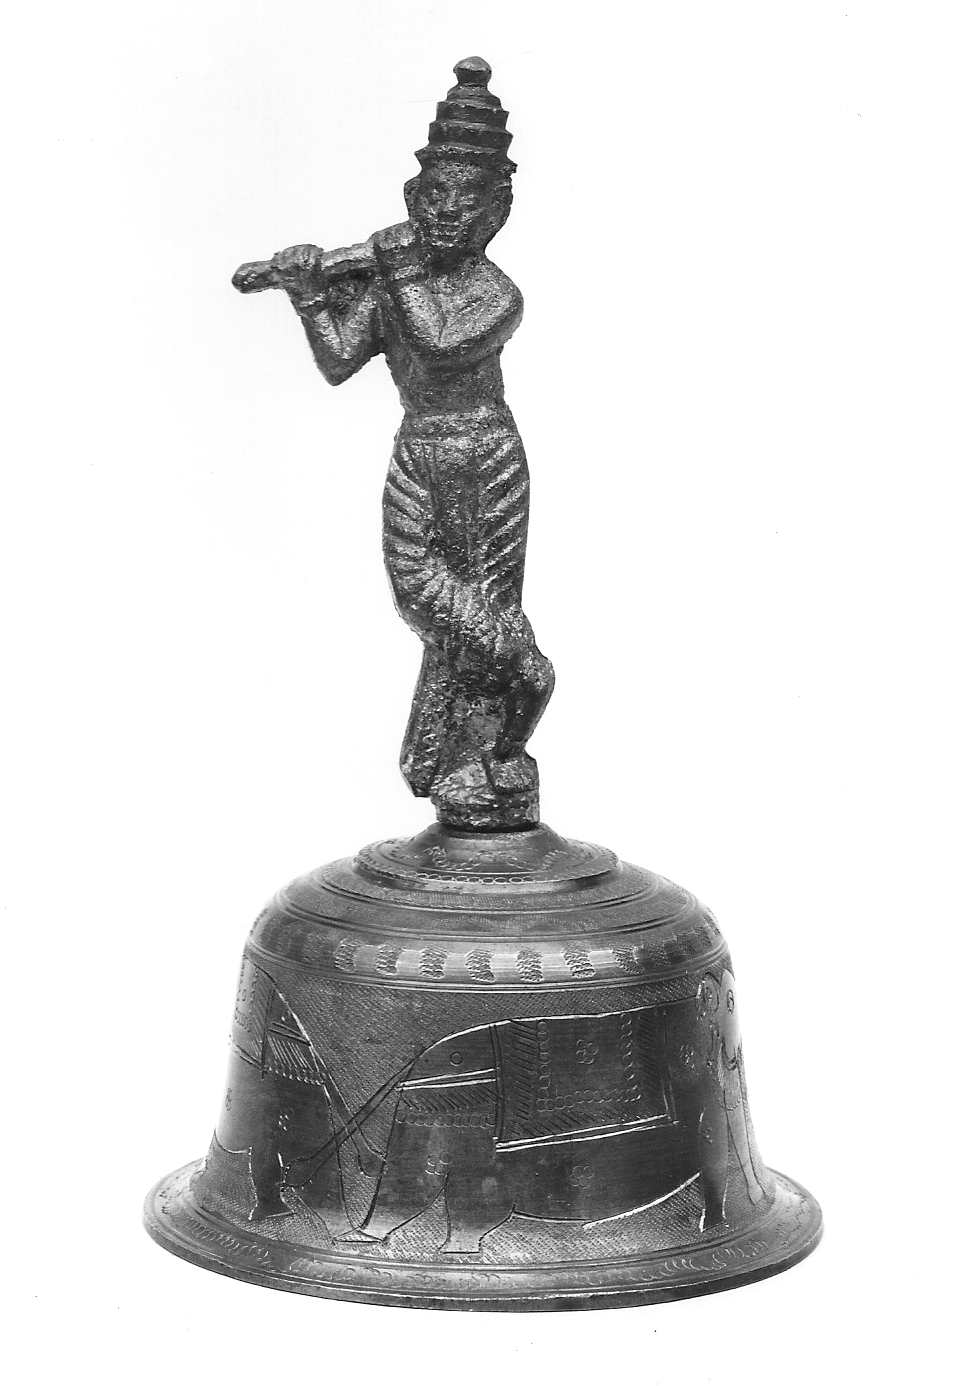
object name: bell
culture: indian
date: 1867-1900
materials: brass, tin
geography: india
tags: human figures